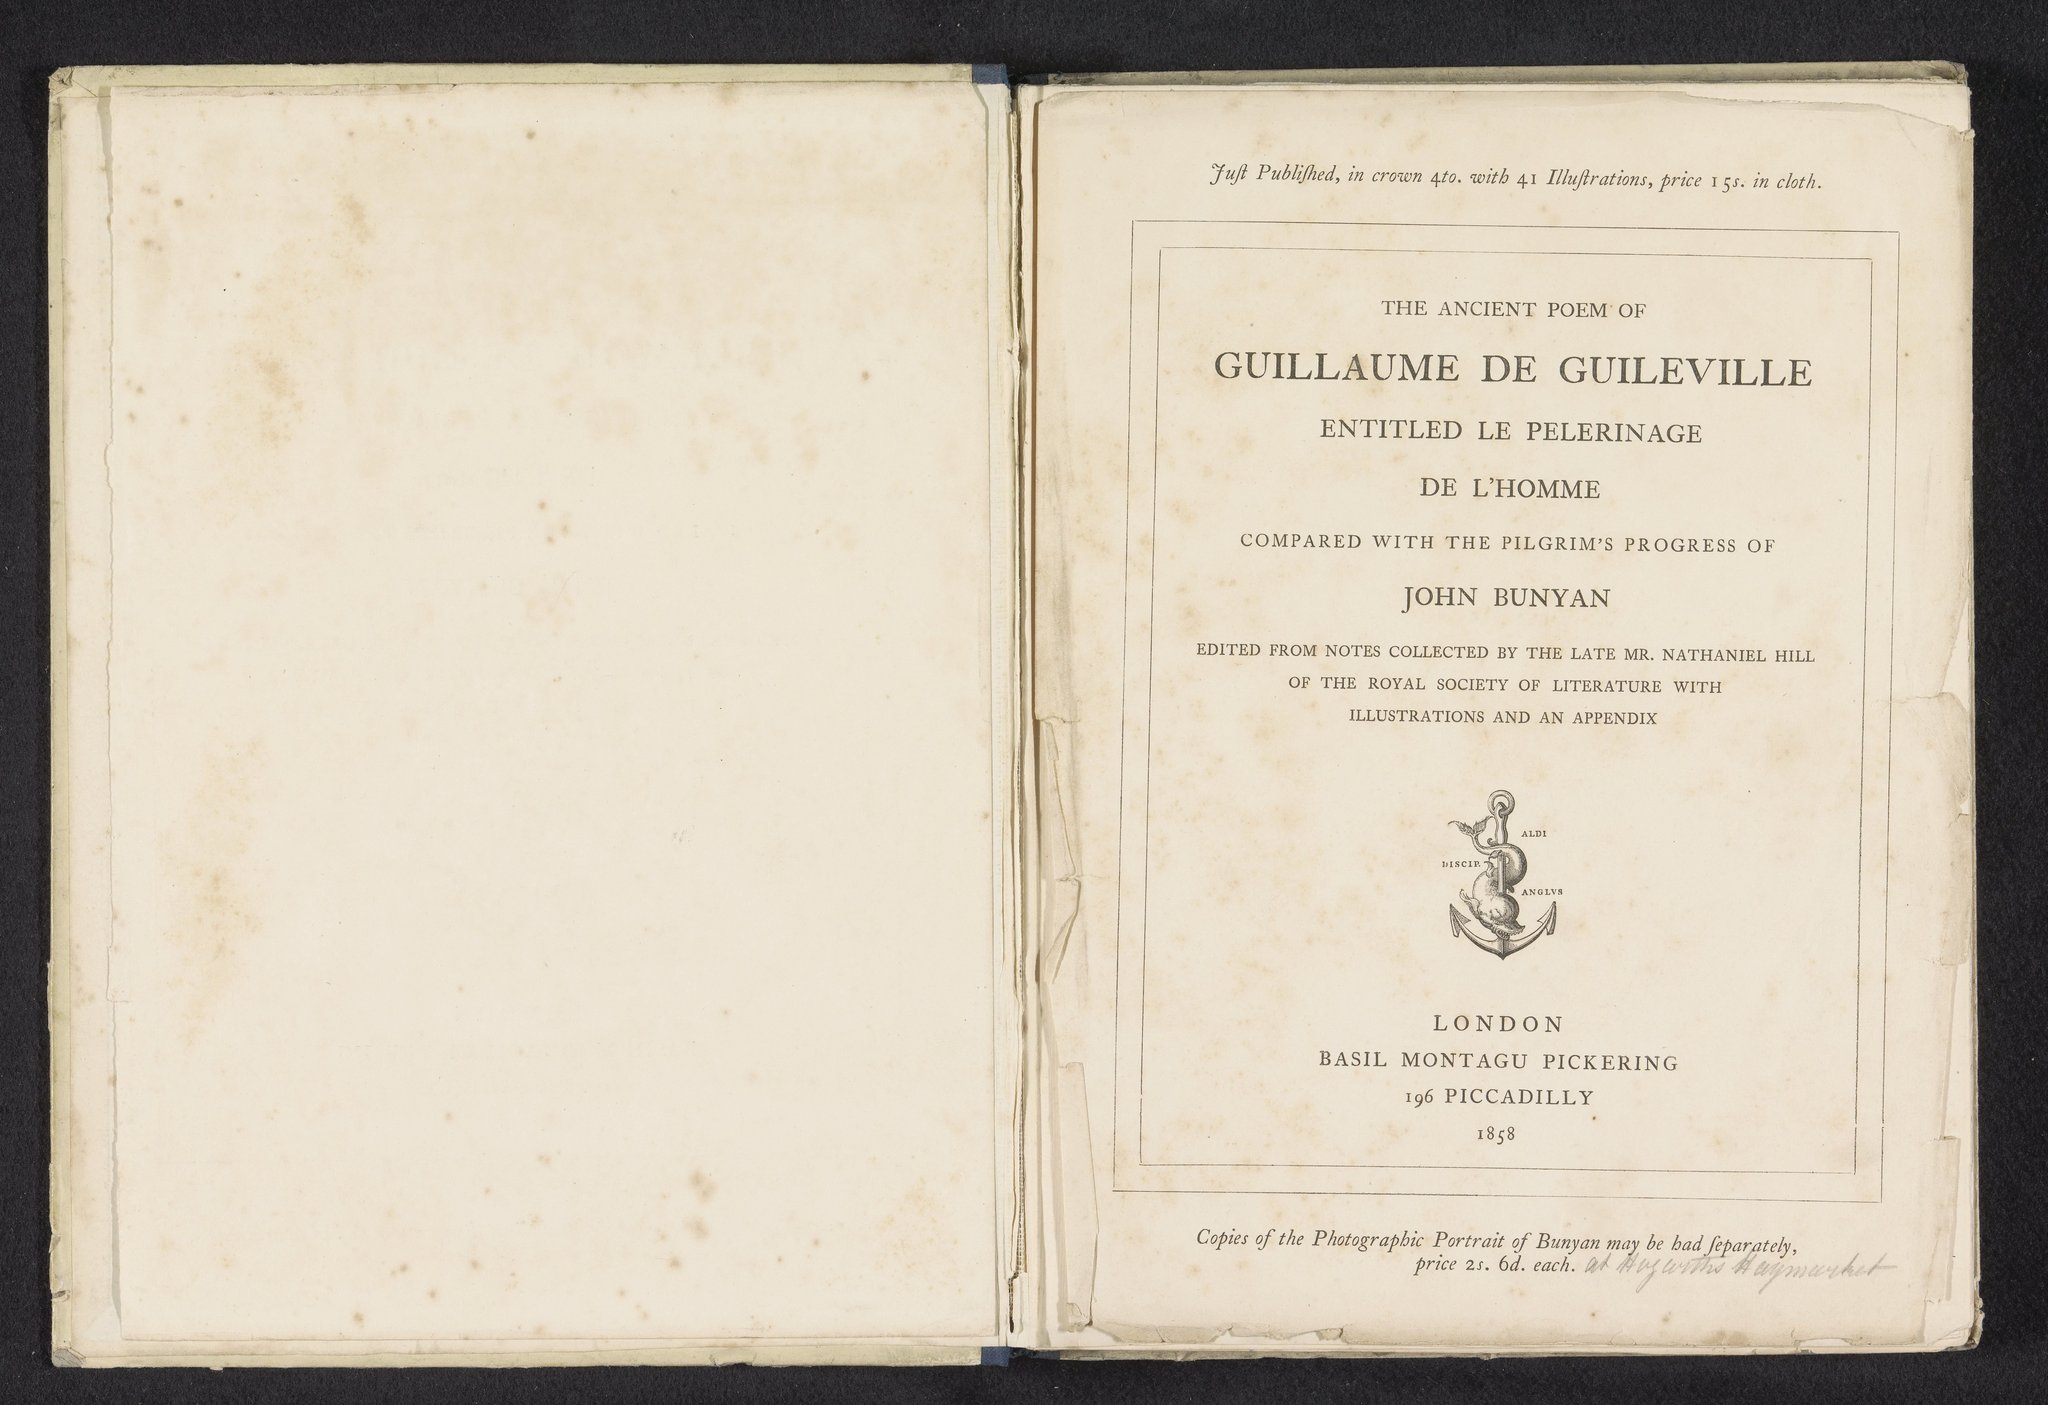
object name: book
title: The ancient poem of Guillaume de Guileville entitled le Pelerinage de l'homme, compared with the Pilgrim's progress of John Bunyan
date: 1858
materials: cardboard, linen, paper, photographic support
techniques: albumen print, lithograph, printing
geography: london